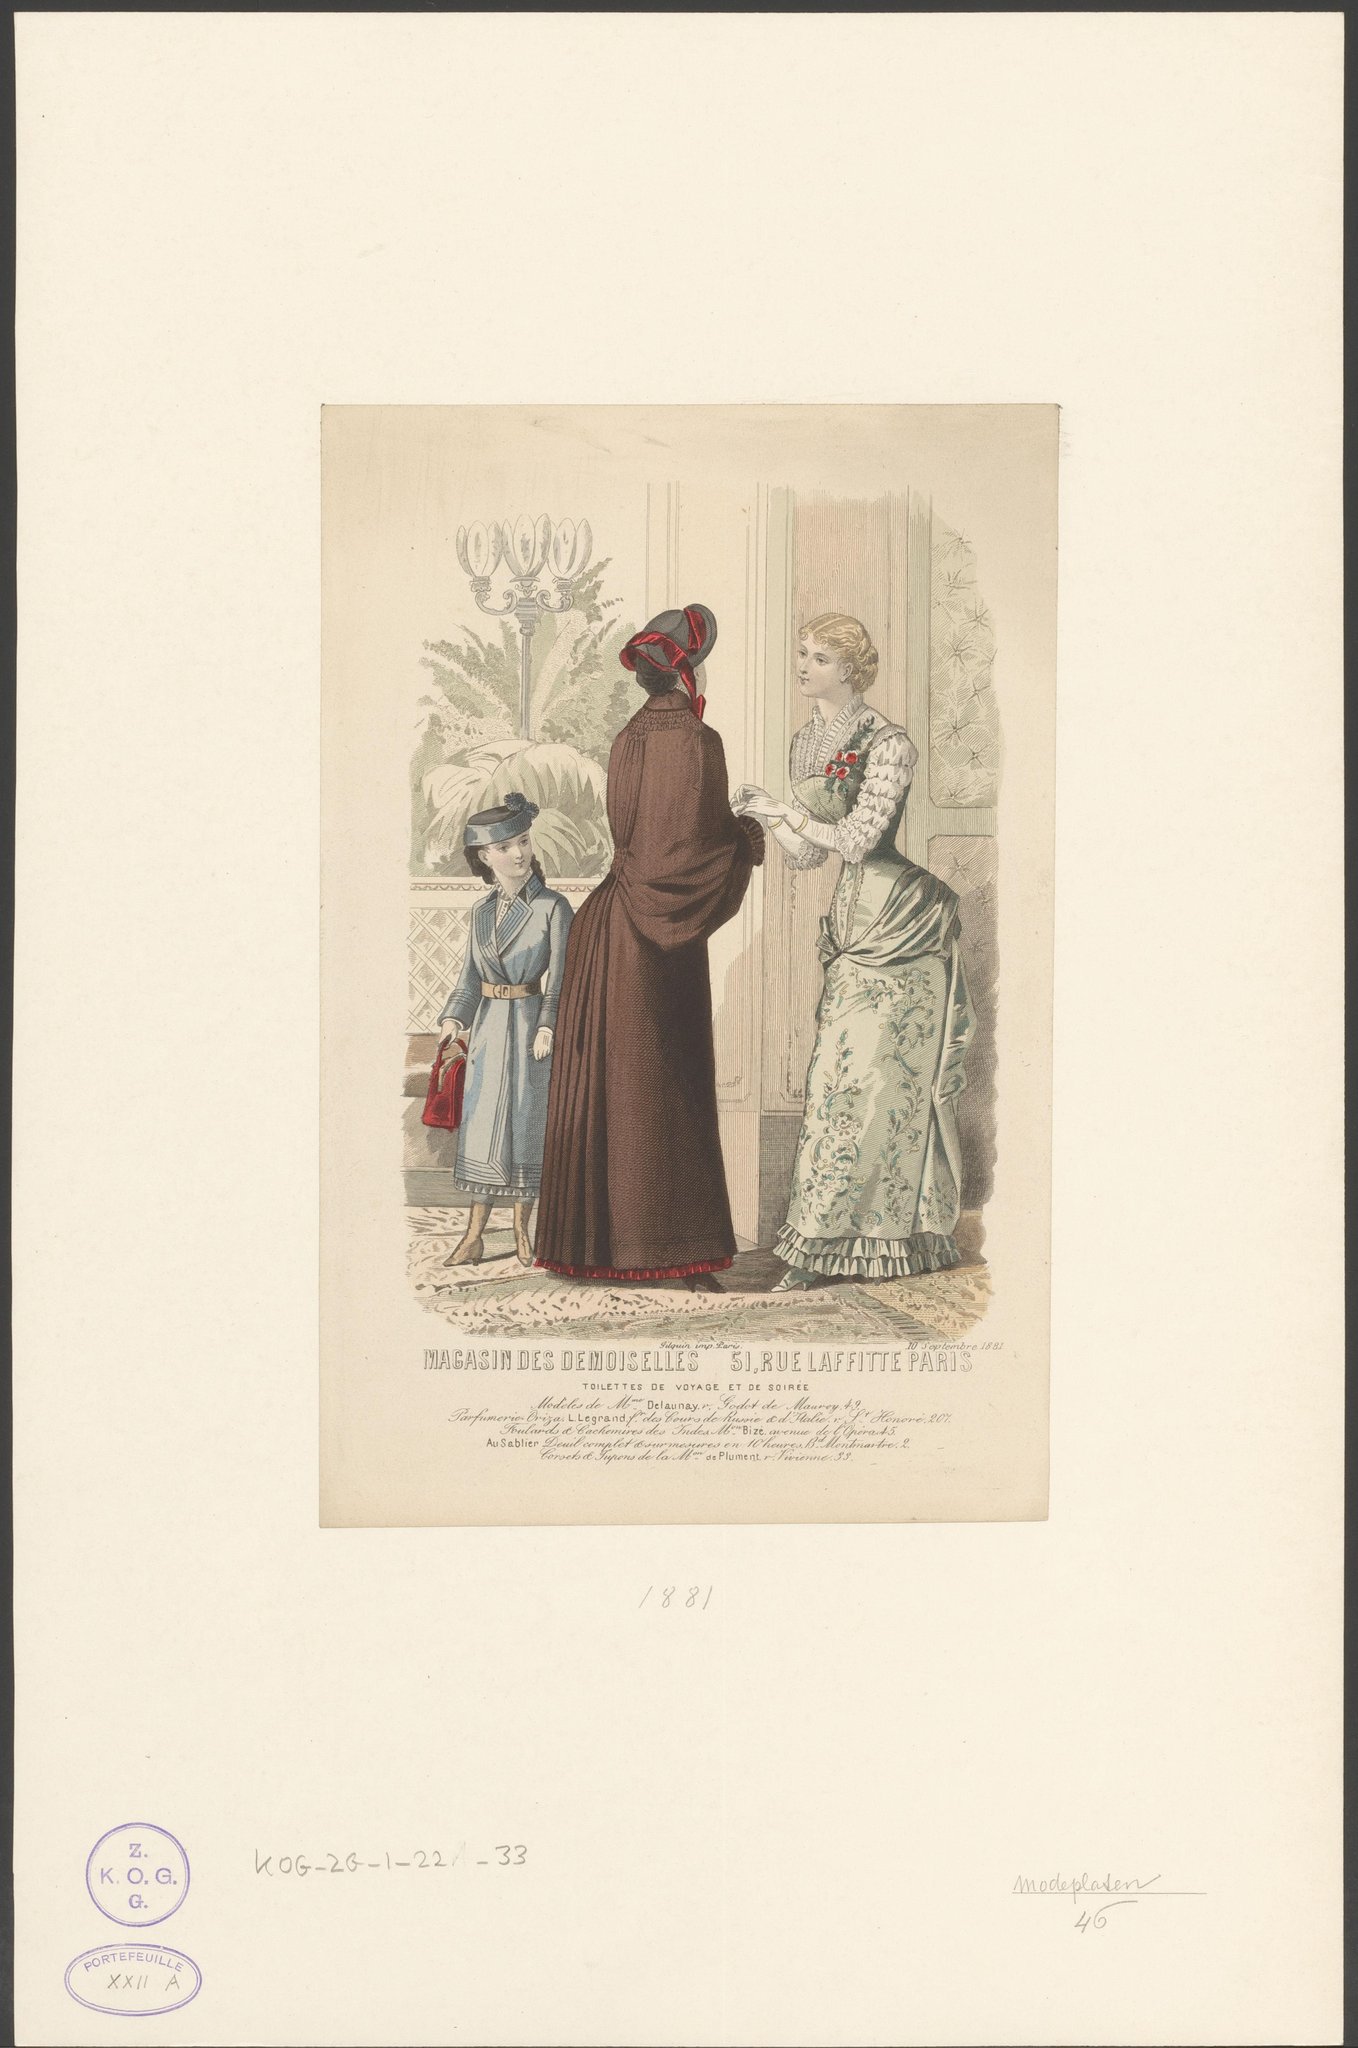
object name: print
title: Magasin des Demoiselles, 10 Septembre 1881 : Toilettes de Voyage et de Soirée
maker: Anonymous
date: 1881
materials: paper, watercolor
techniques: etching, hand coloring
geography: france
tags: fashion plates, clothes, costume (+ women's clothes), dress, gown (+ women's clothes), departure ~ travelling, taking leave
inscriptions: collector's mark, collector's mark: Lugt 1641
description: Een vrouw en een meisje in reiskleding nemen afscheid van een andere vrouw. Onder de voorstelling volgen enkele regels reclametekst voor verschillende producten. Prent uit het modetijdschrift Magasin des Demoiselles (1844-1896). Onderwerpsrubrieken binnen de Atlas Zeden en Gewoonten: De Kleeding, Modeplaten.